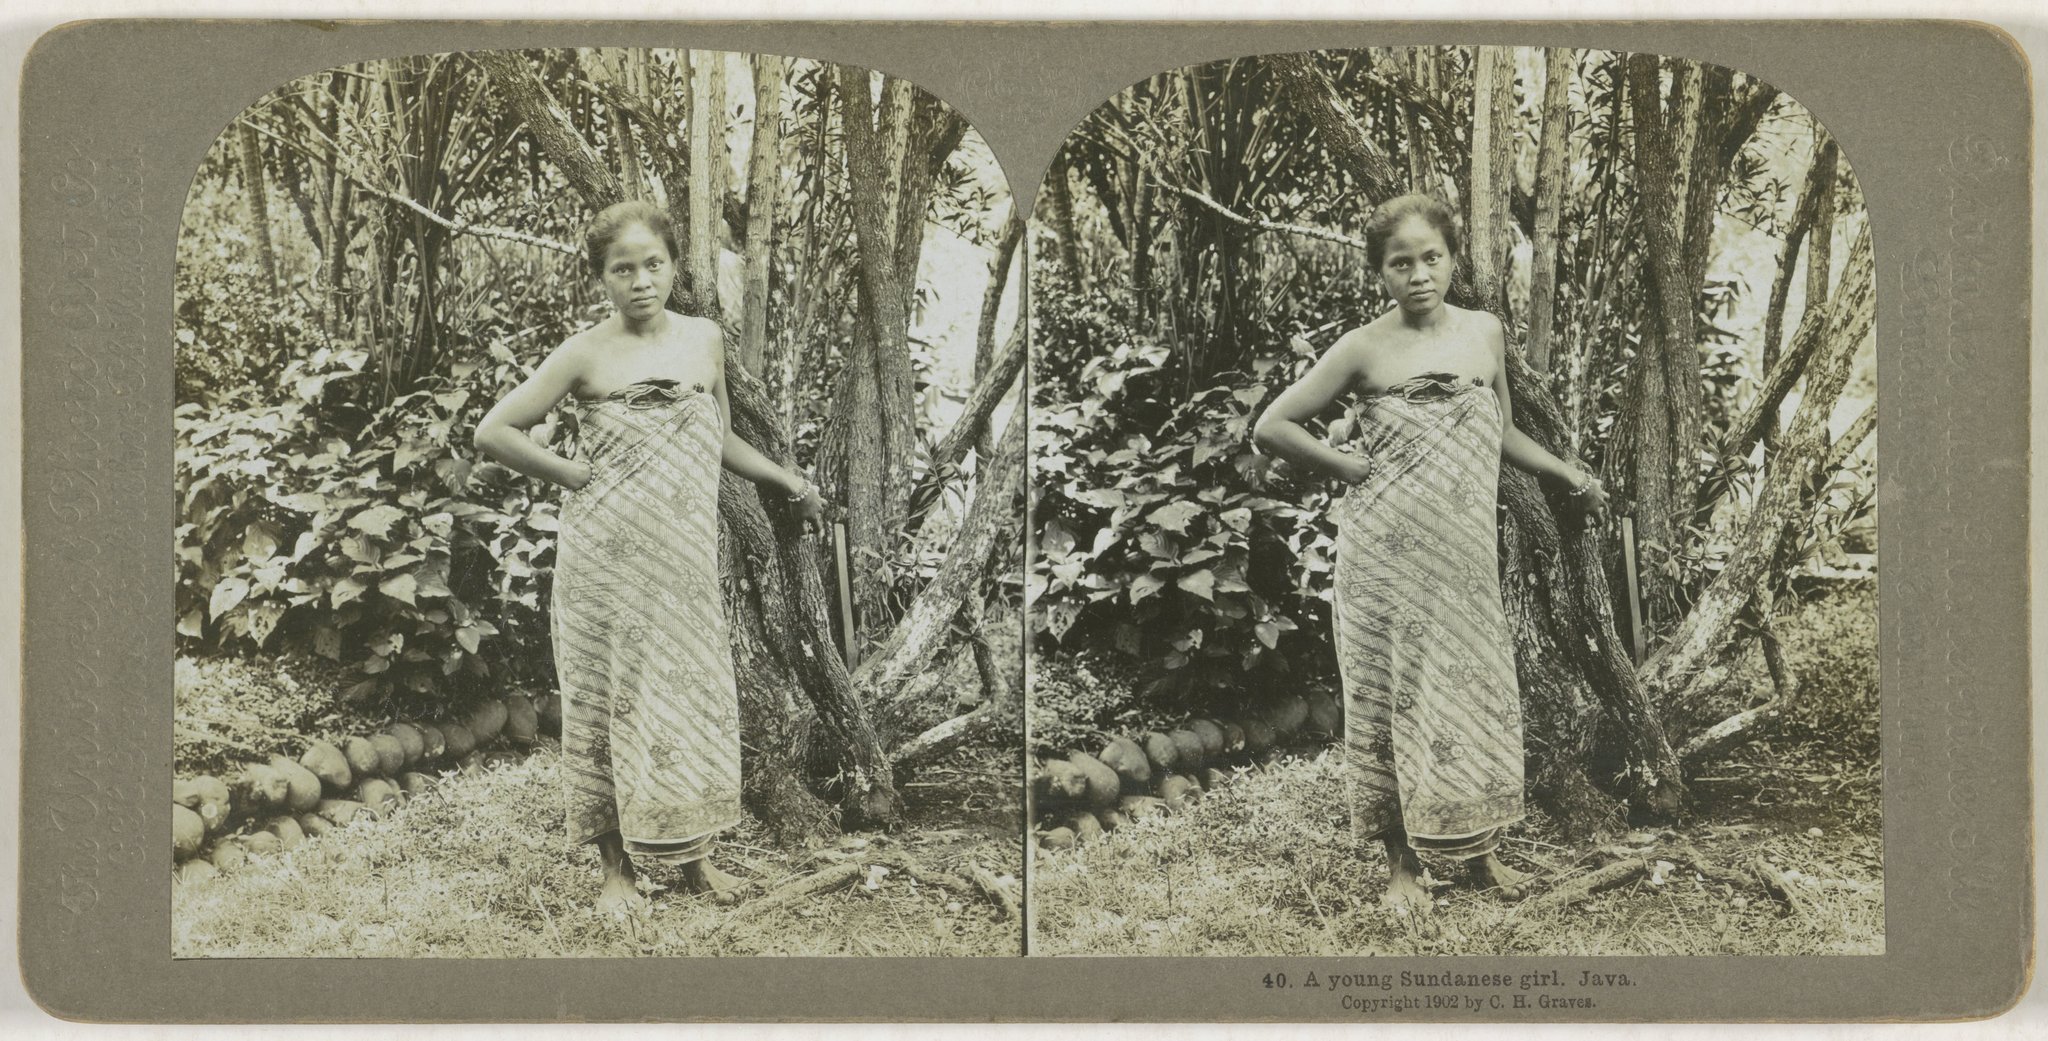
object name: stereograph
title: Soedanese vrouw op Java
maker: carleton harlow graves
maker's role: fotograaf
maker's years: 1867-1943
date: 1902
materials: paper, cardboard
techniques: gelatin silver print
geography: philadelphia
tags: adult woman, java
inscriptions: number: ‘37’, copyright notice: ‘Copyright 1902 by C. H. Graves.’